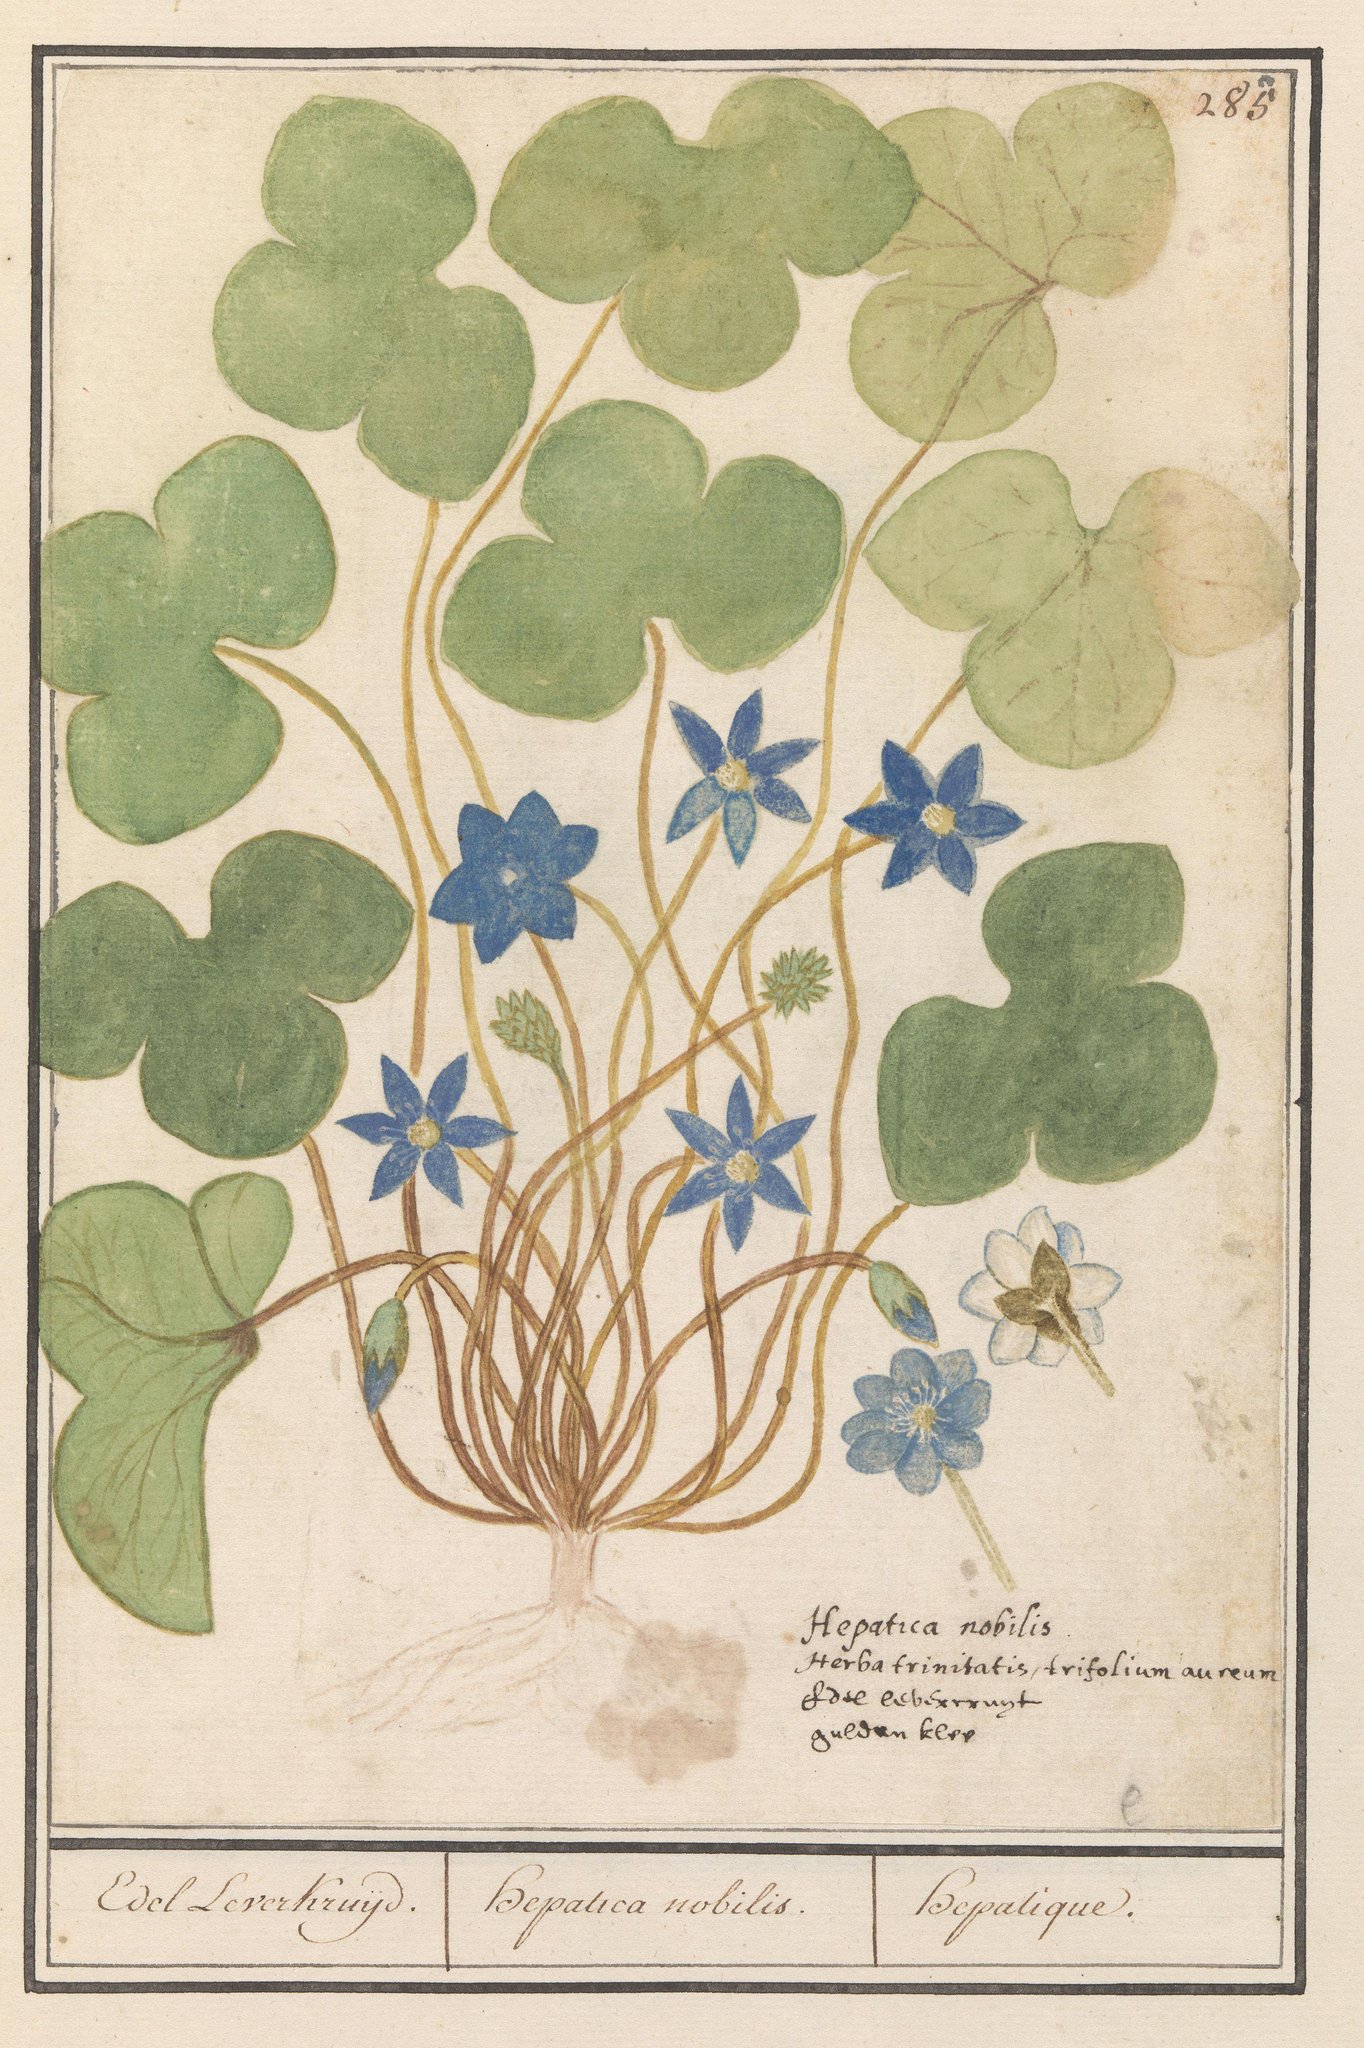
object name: drawing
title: Leverbloempje (Anemone hepatica, oude naam: Hepatica nobilis)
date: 1596-1610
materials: chalk, paint, ink, paper, watercolor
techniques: brush, pen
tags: flowers: anemone hepatica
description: Leverbloempje. Genummerd rechtsboven: 285. Rechtsonder de naam in Latijn en Nederlands. Onderdeel van het derde album met tekeningen van bloemen en planten. Tiende van twaalf albums met tekeningen van dieren, vogels en planten bekend rond 1600, gemaakt in opdracht van keizer Rudolf II. Met toelichting in Nederlands, Latijn en Frans.